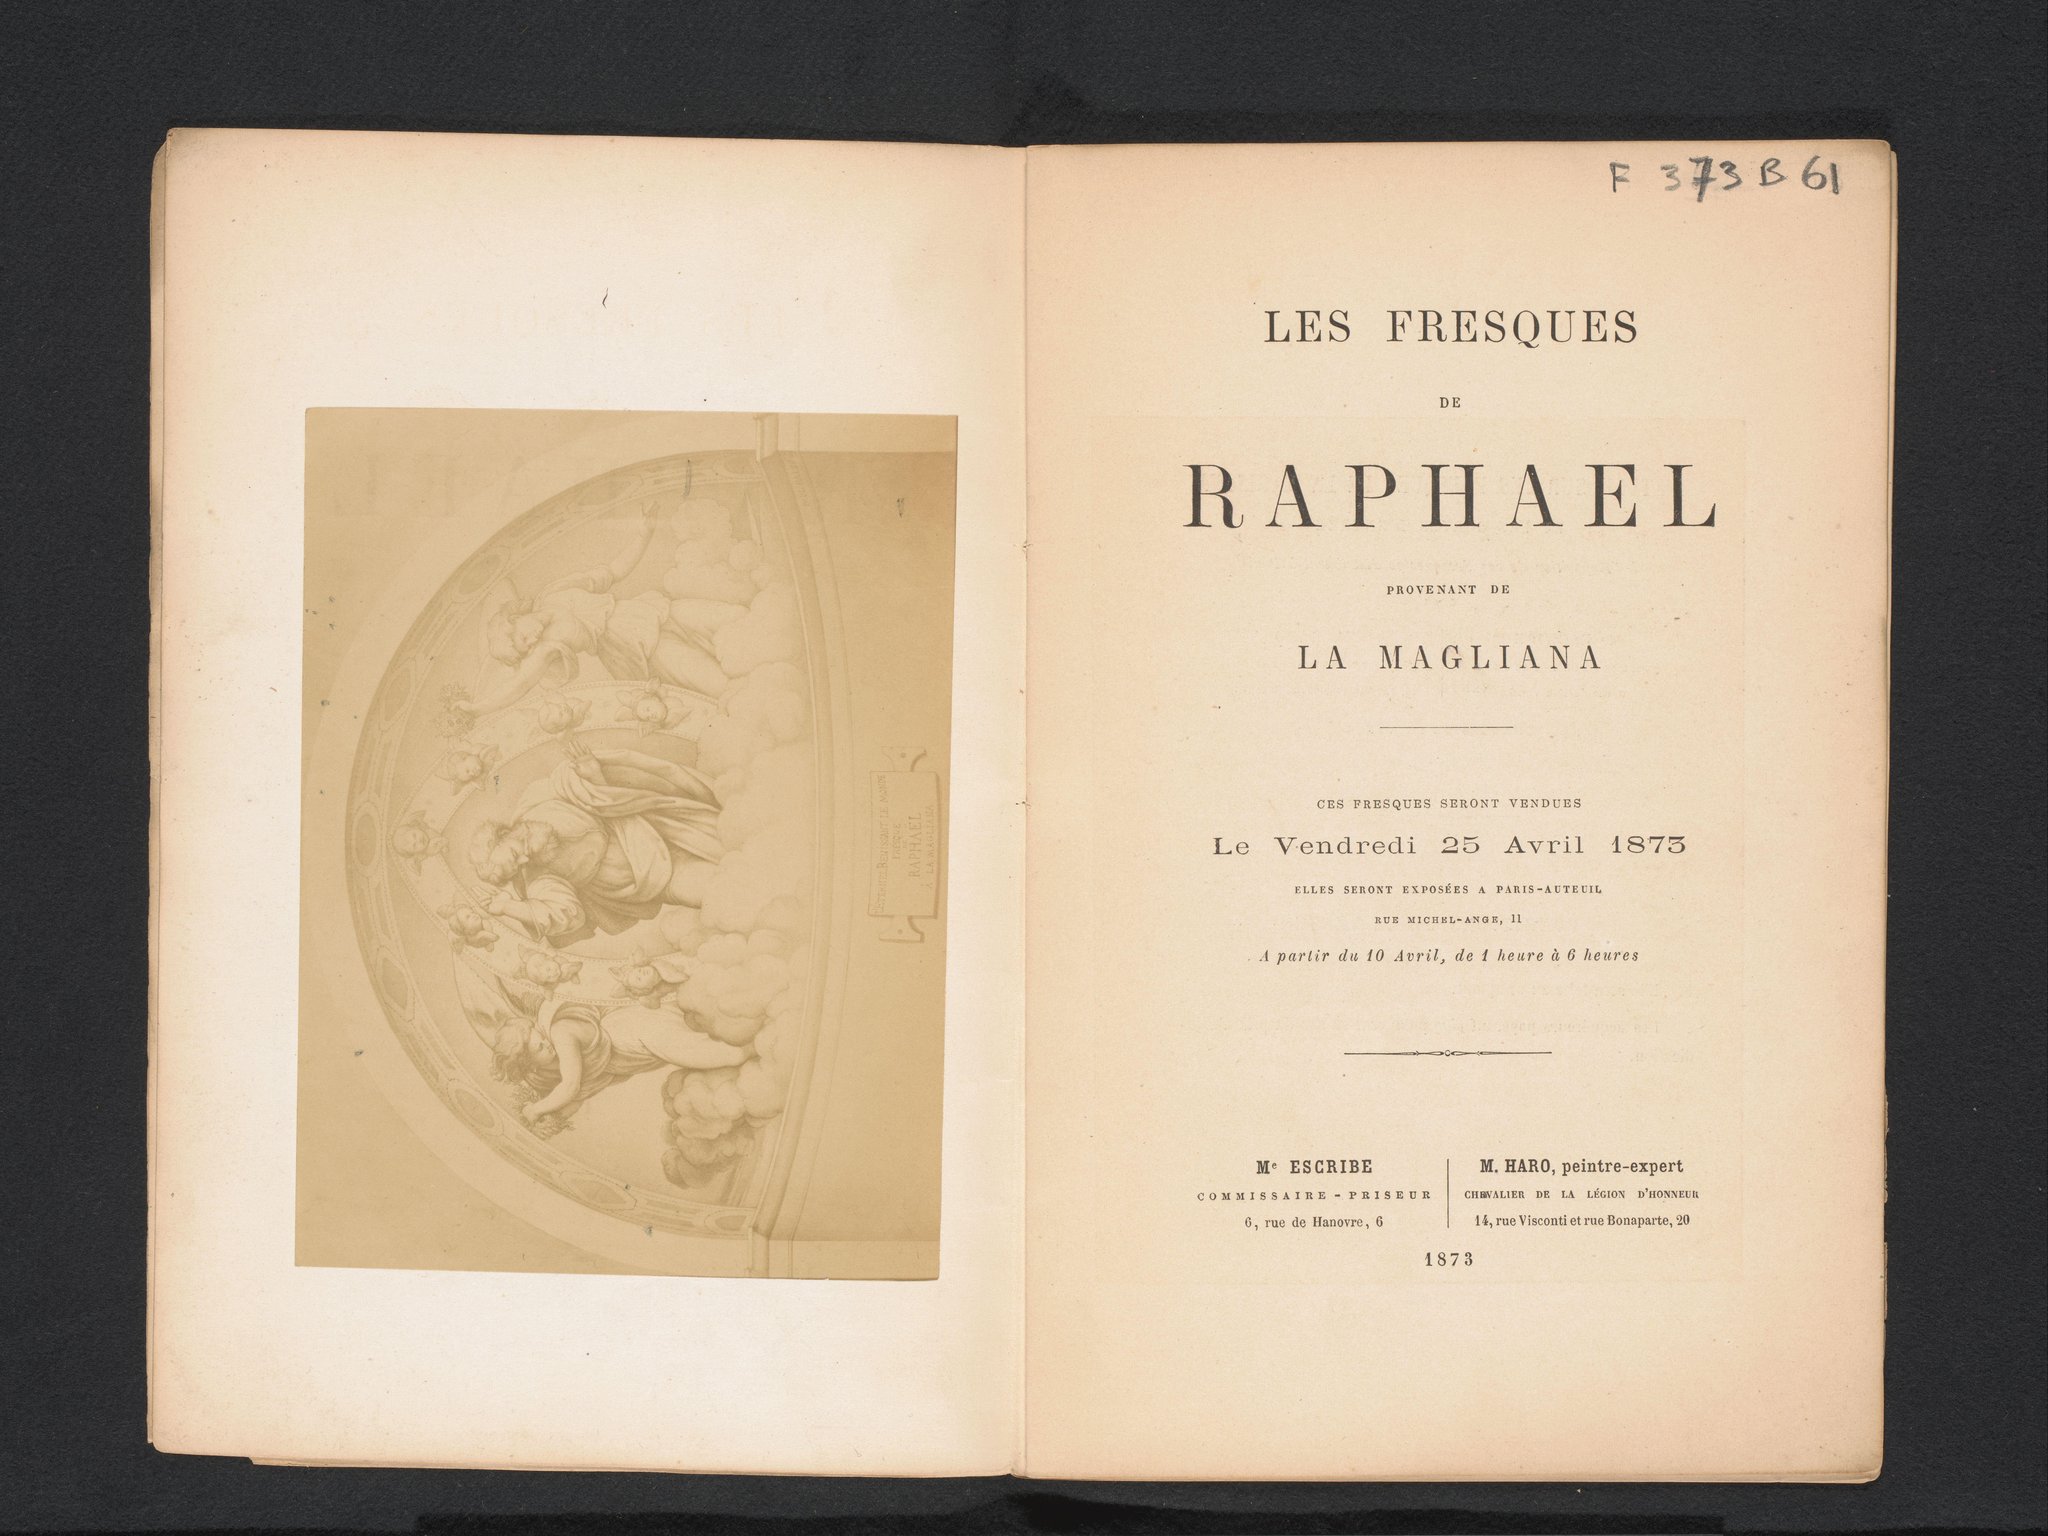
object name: page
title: Fresco van God die de wereld zegent door Rafaël, uit de kapel van een villa in La Magliana, Rome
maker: Anonymous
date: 1868-1873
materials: photographic support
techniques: albumen print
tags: picture, painting, god the father represented as human being, usually with crown or tiara or sceptre and/or globe